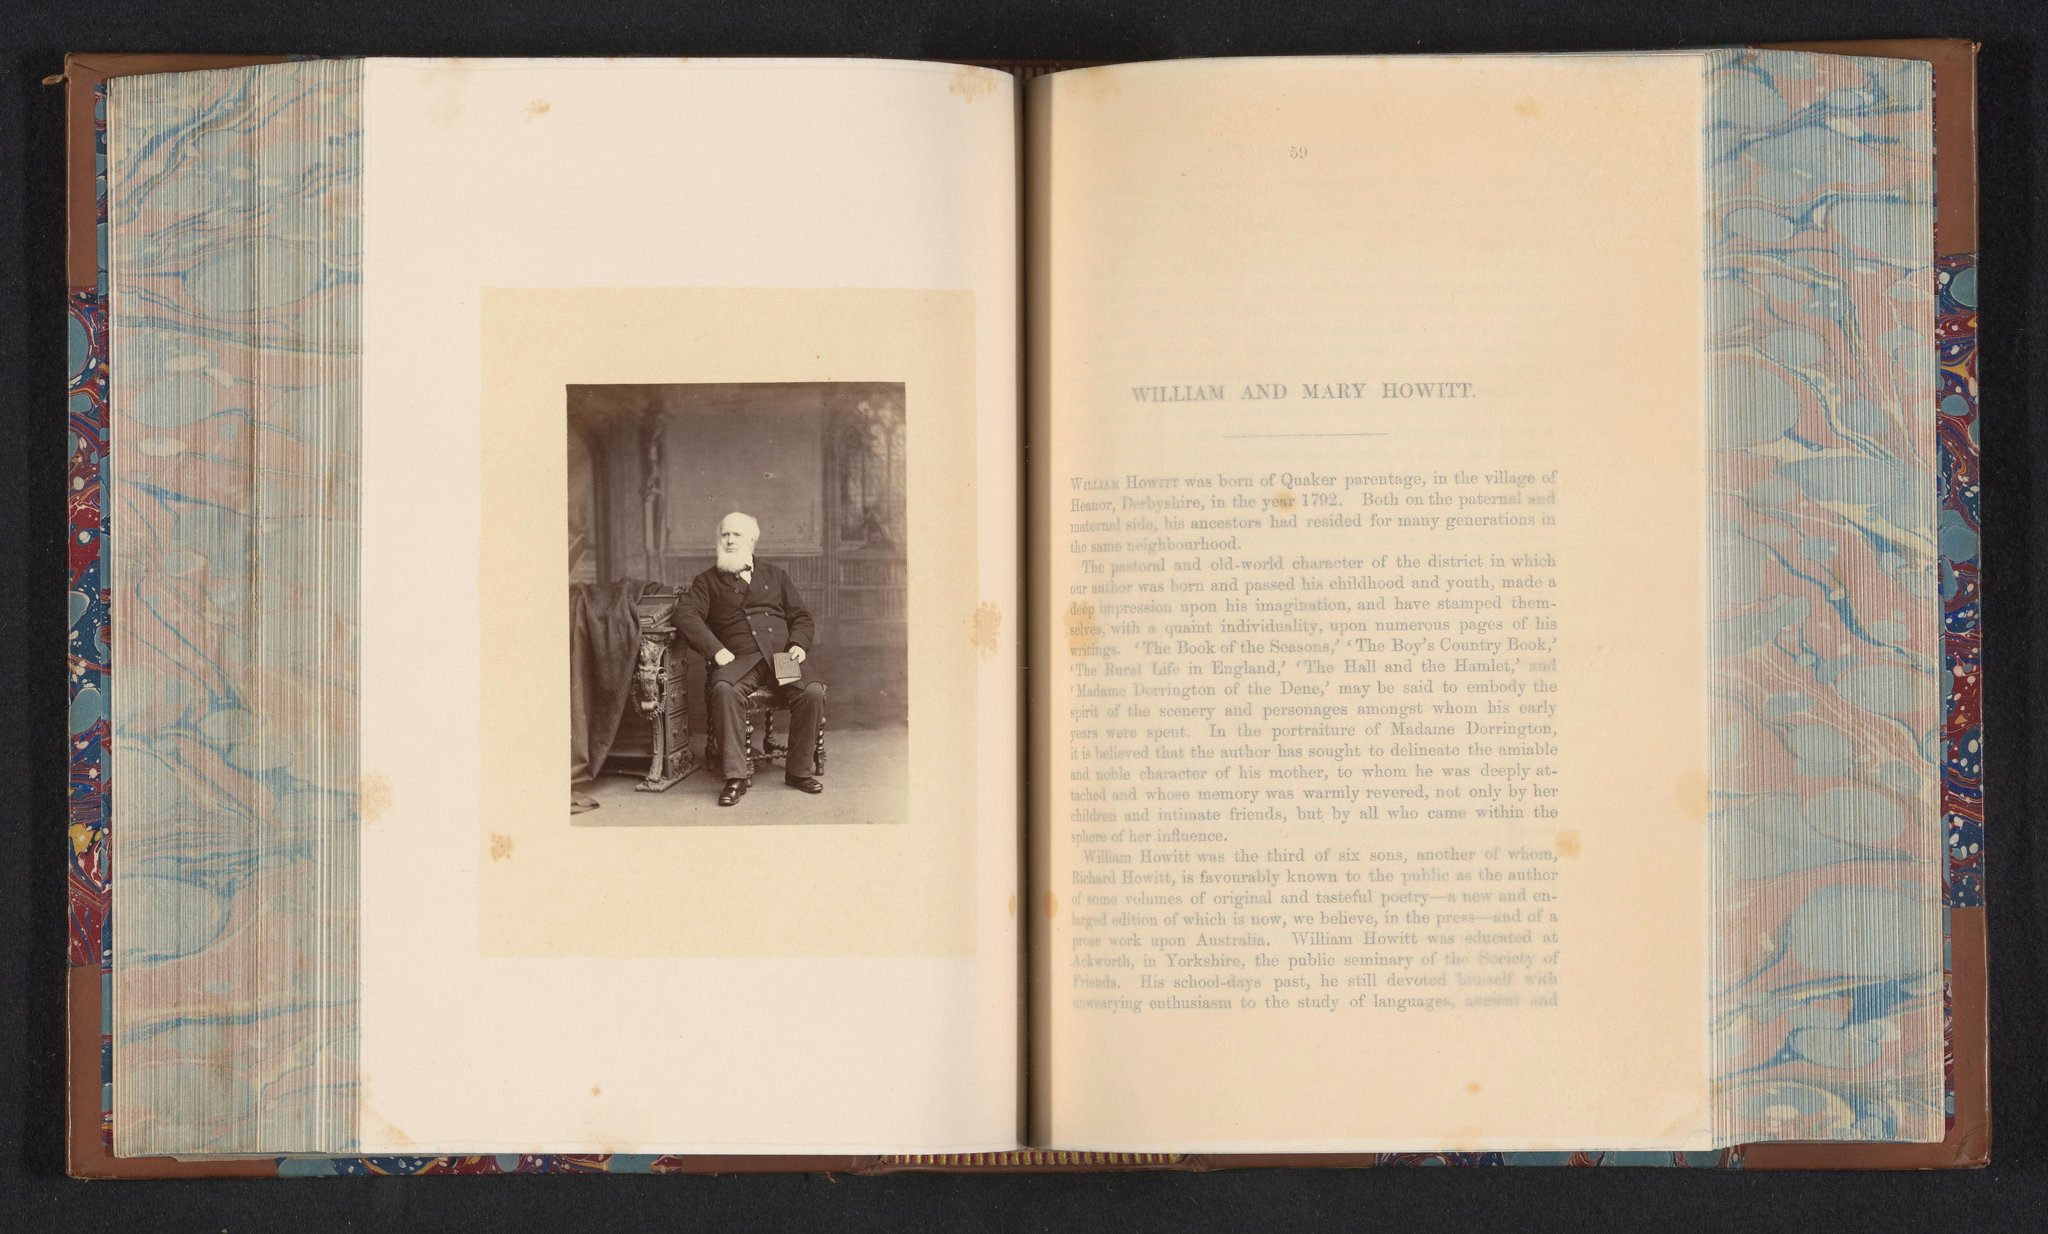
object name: page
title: Portret van William Howitt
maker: ernest edwards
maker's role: fotograaf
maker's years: 1837-1903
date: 1853-1867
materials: photographic support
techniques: albumen print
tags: william howitt, studio ~ photographer, portrait of a writer